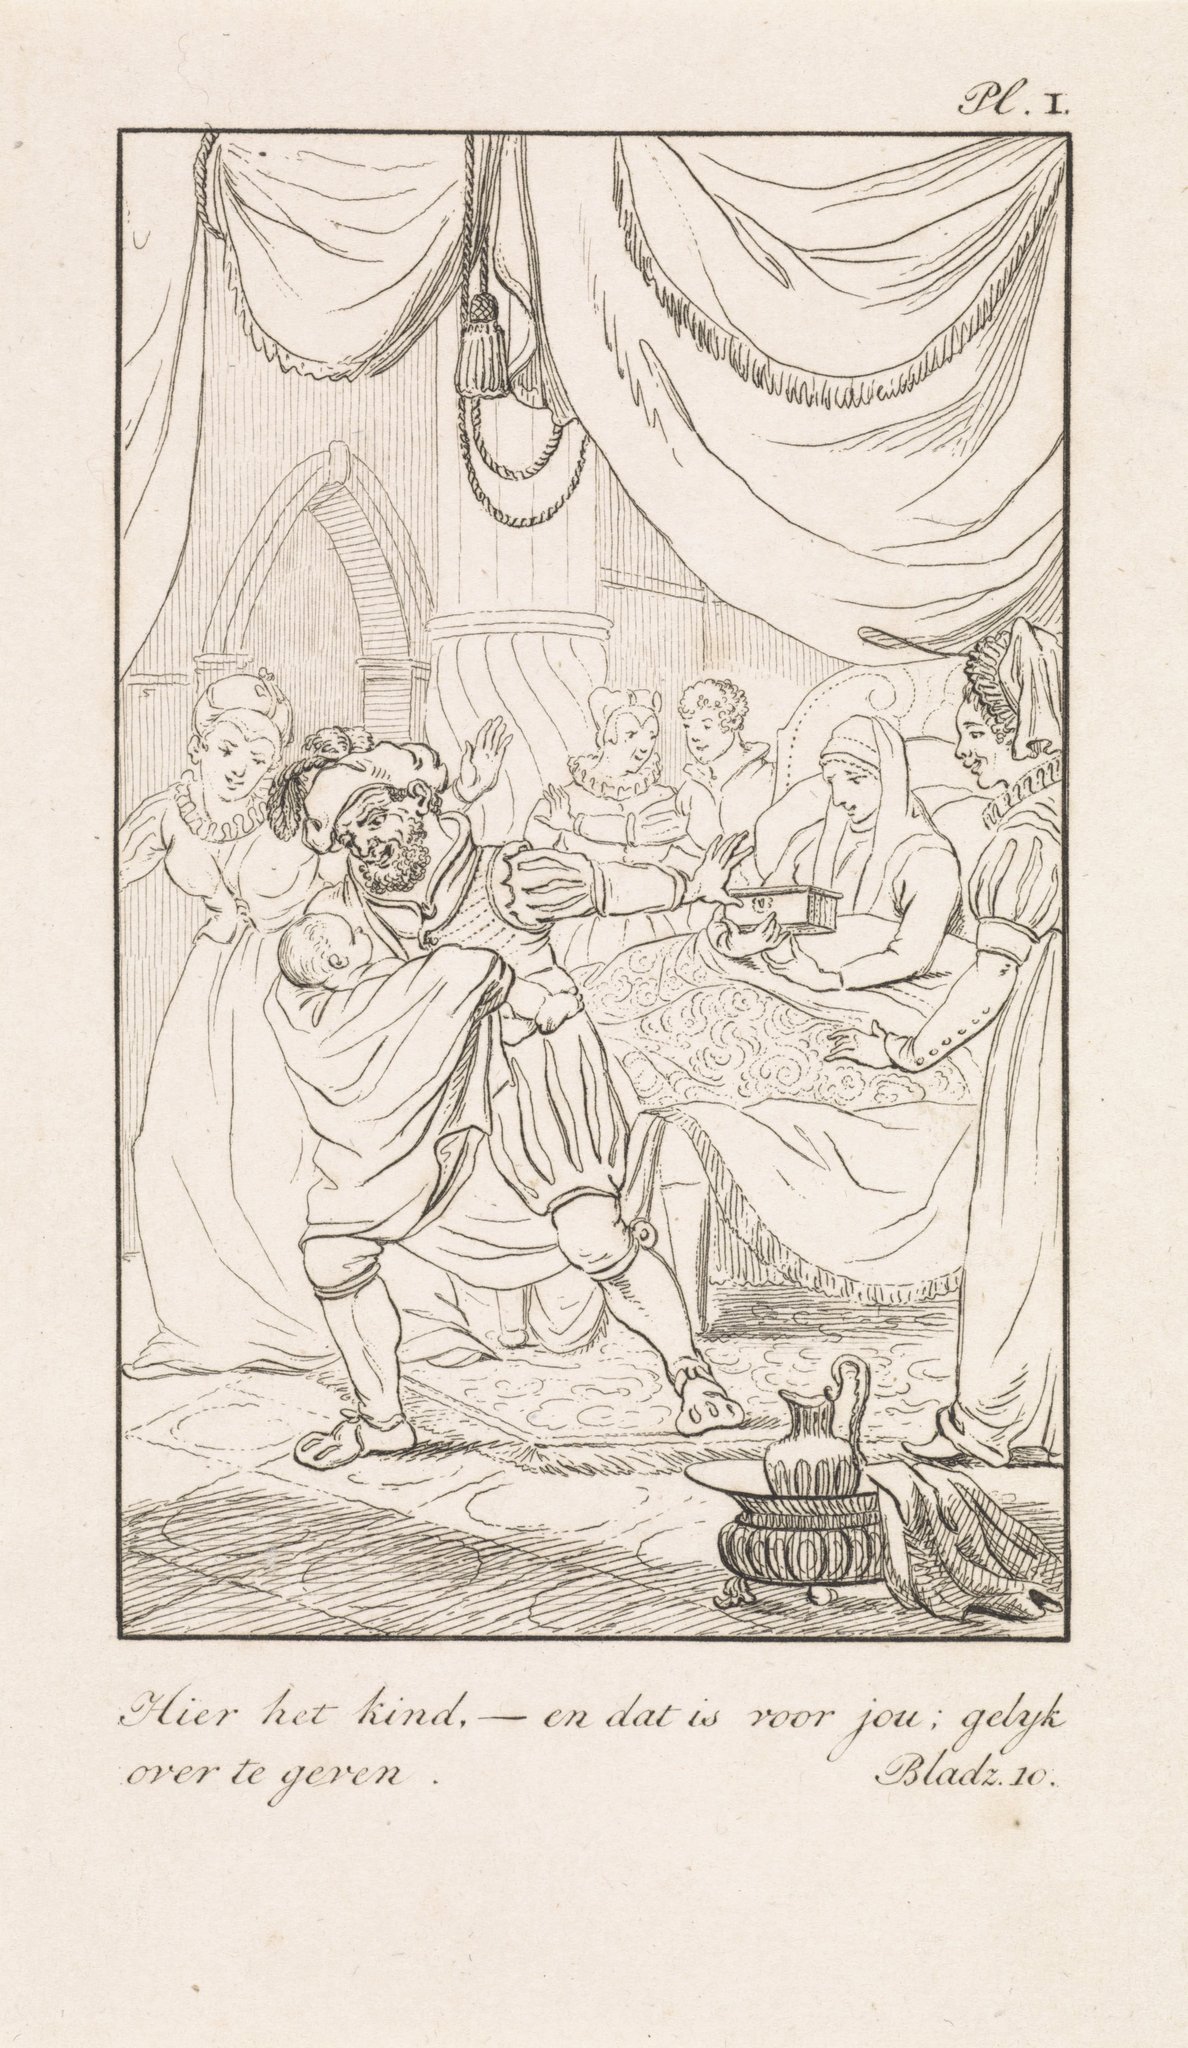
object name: print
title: Man met een kind in een kraamkamer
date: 1802-1809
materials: paper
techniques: etching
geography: haarlem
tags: lying-in room, political caricatures and satires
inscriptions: collector's mark: Lugt 2228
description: Prent als boekillustratie gebruikt in: Fokke Simonsz., Arend. Het hoekjen van den haard of Historie van Frankrijk. Deel IV-VII uit: Boertige Reis door Europa. 7 dln. Haarlem: François Bohn, 1802-1809.